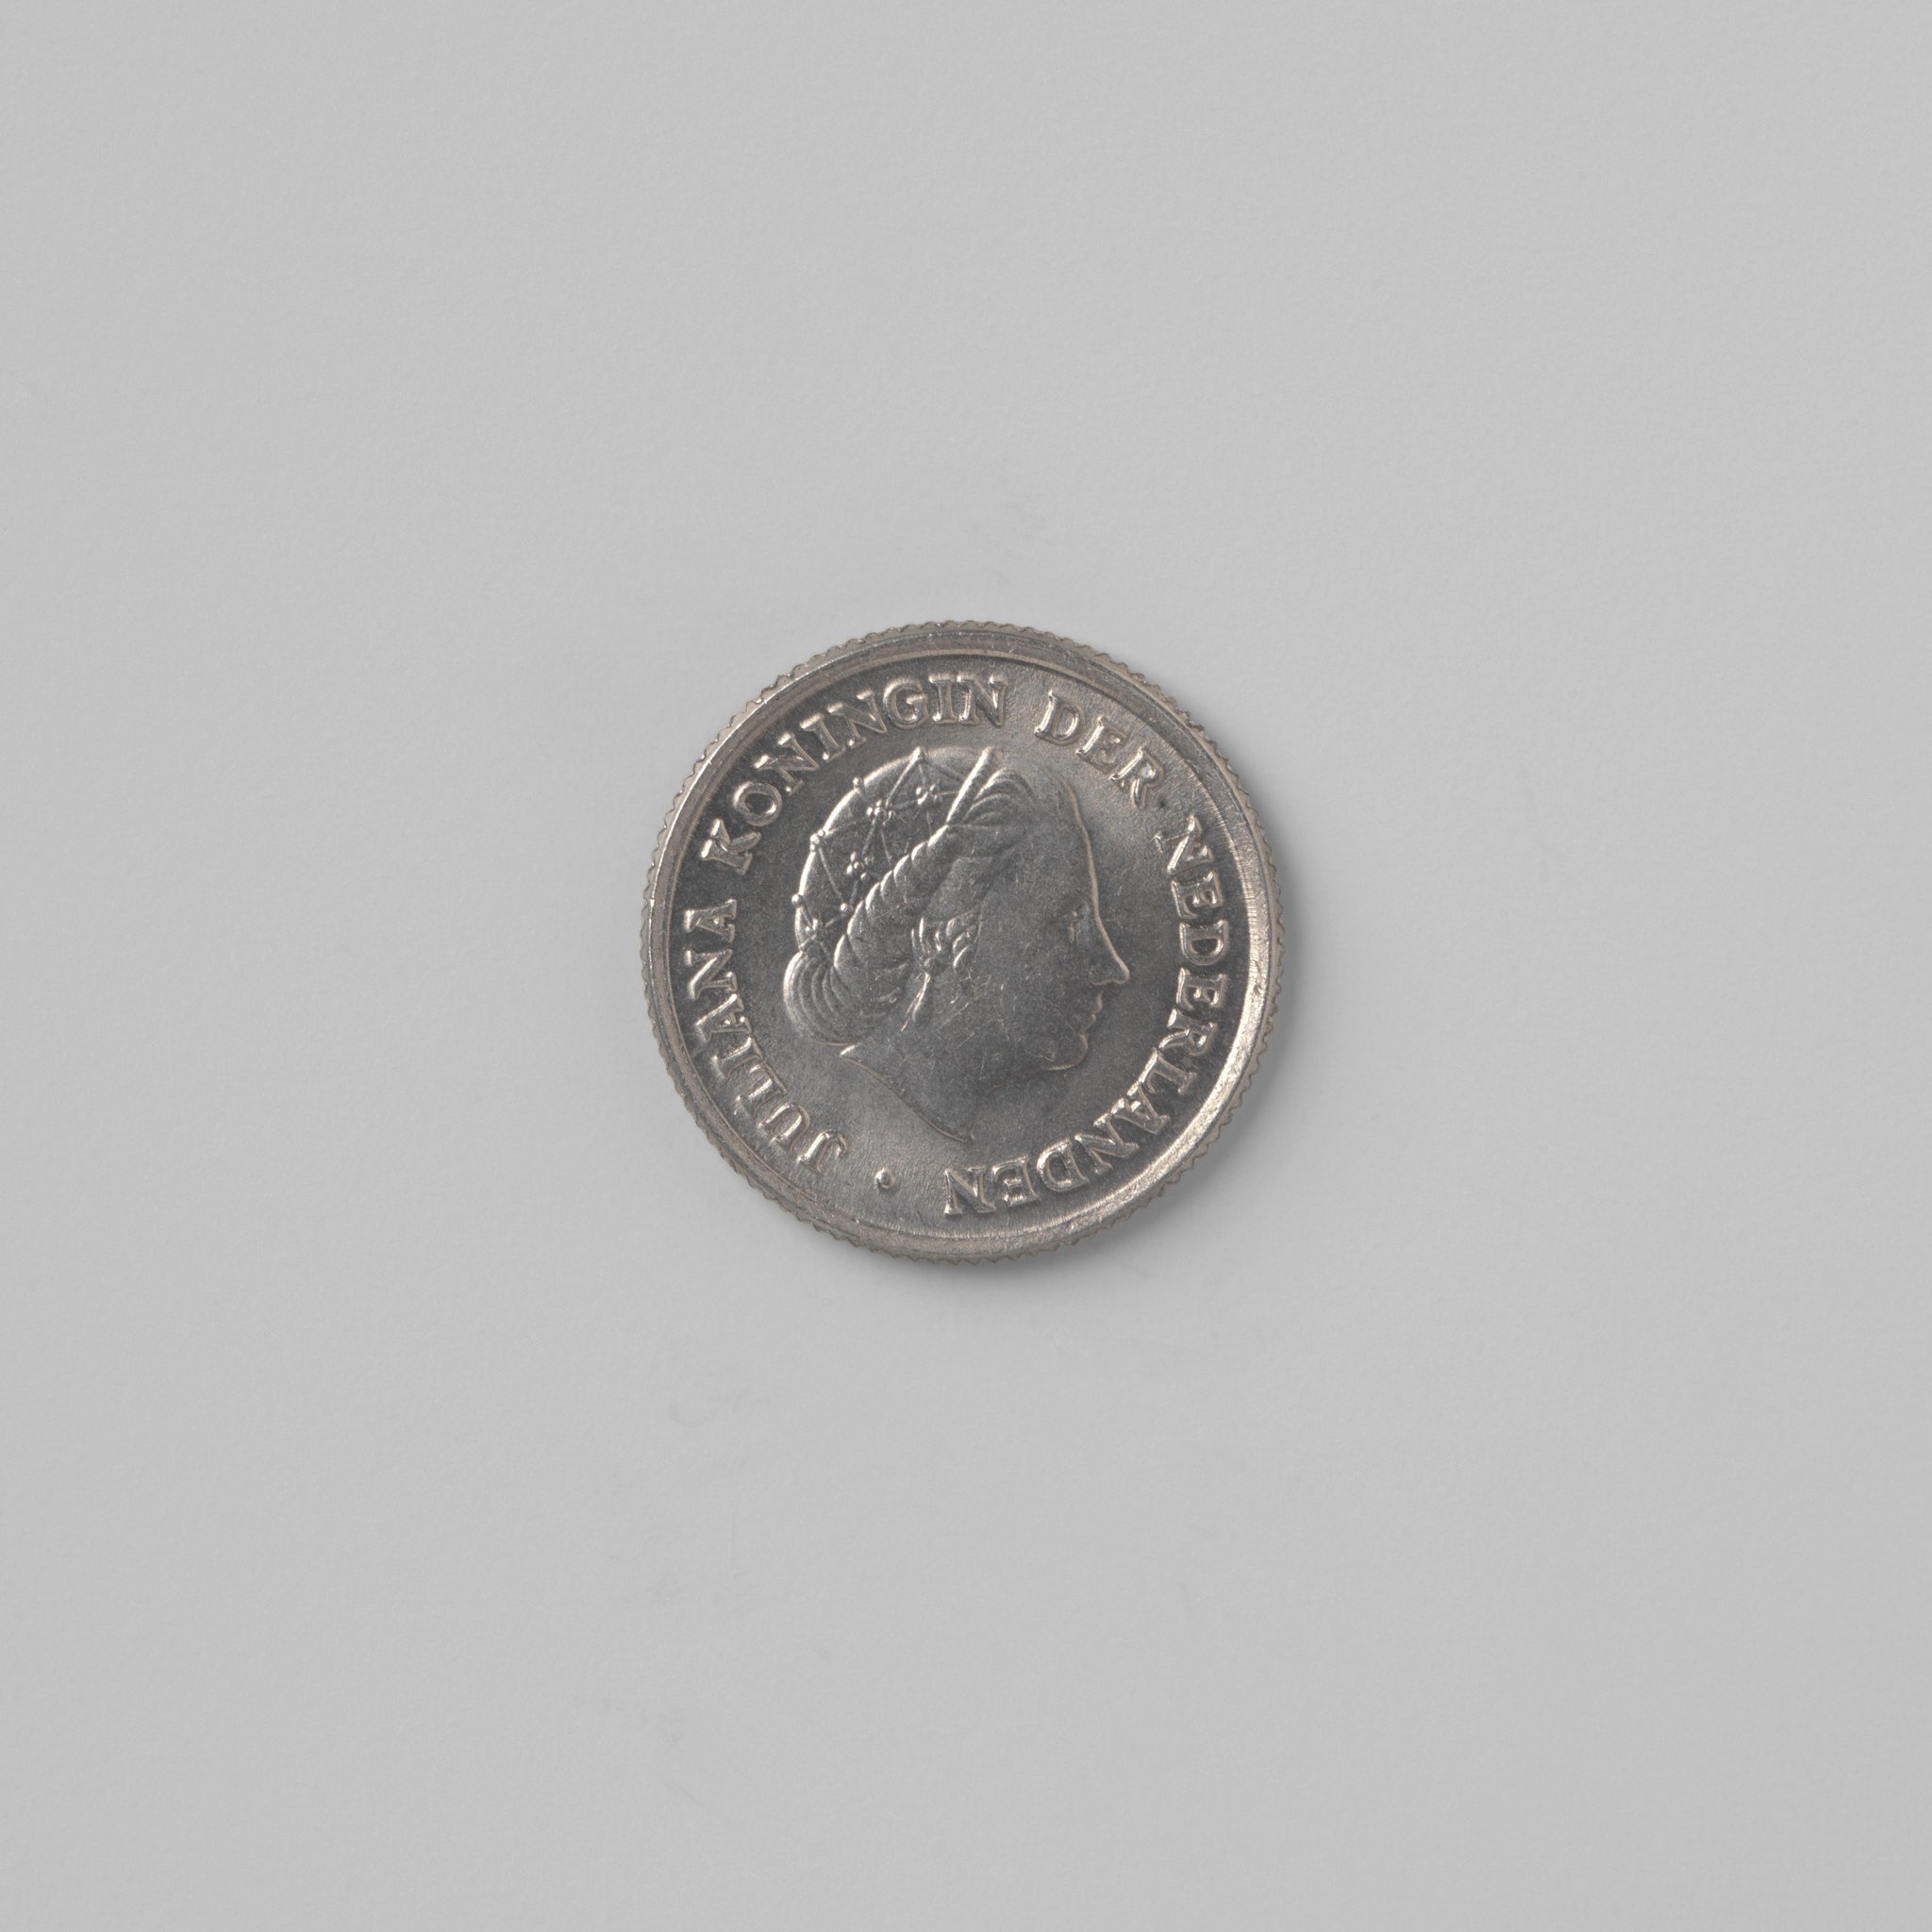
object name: coin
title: Nederlandse 10 cent,1950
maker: juliana of the netherlands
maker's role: koningin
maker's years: 1909-2004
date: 1950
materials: nickel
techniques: striking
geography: utrecht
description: Nikkelen munt. Voorzijde: hoofd naar rechts. Keerzijde: kroon, daaronder, tussen jaartal, waarde-aanduiding 10 cent. Kartelrand.